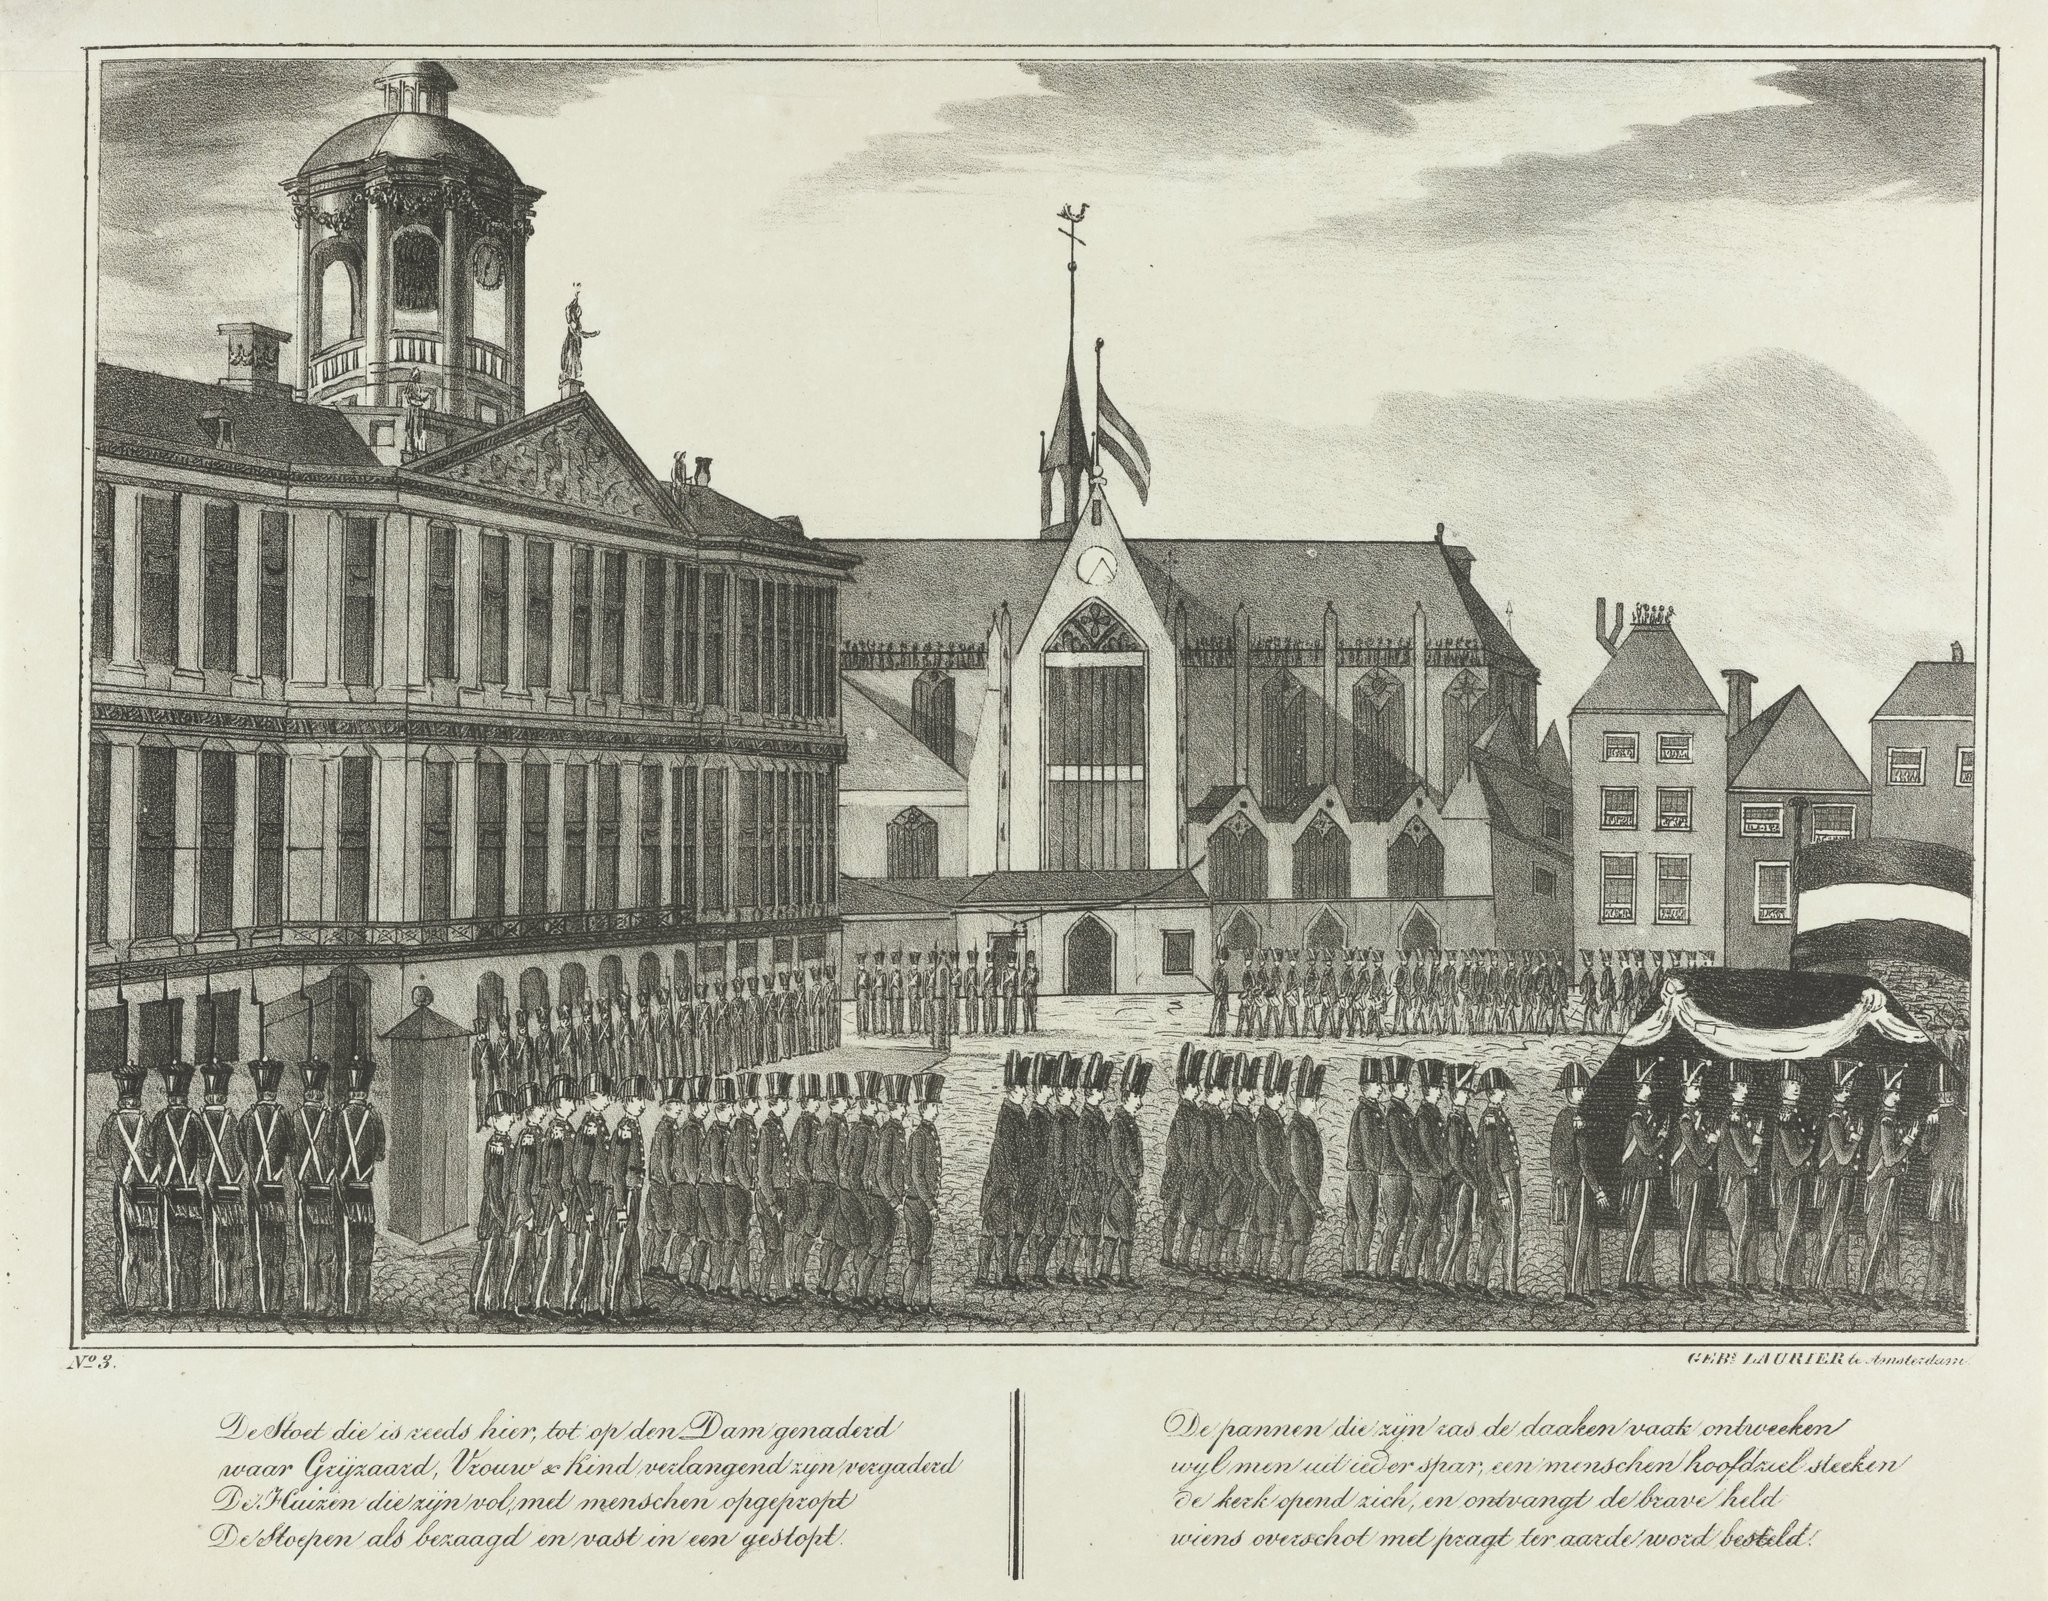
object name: print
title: Aankomst van de lijkstoet van Jan van Speyk op de Dam, 1832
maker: Anonymous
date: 1832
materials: paper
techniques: lithograph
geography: amsterdam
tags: amsterdam, antwerp, jan van speyk, cortege, funeral procession, royal palace of amsterdam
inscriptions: collector's mark: Lugt 2228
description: Aankomst van de lijkstoet met de stoffelijke resten van Jan van Speyk op de Dam te Amsterdam. In het onderschrift twee vierregelige verzen. Derde plaat in een serie van vier platen van de begrafenis van Jan van Speyk te Amsterdam op 4 met 1832.